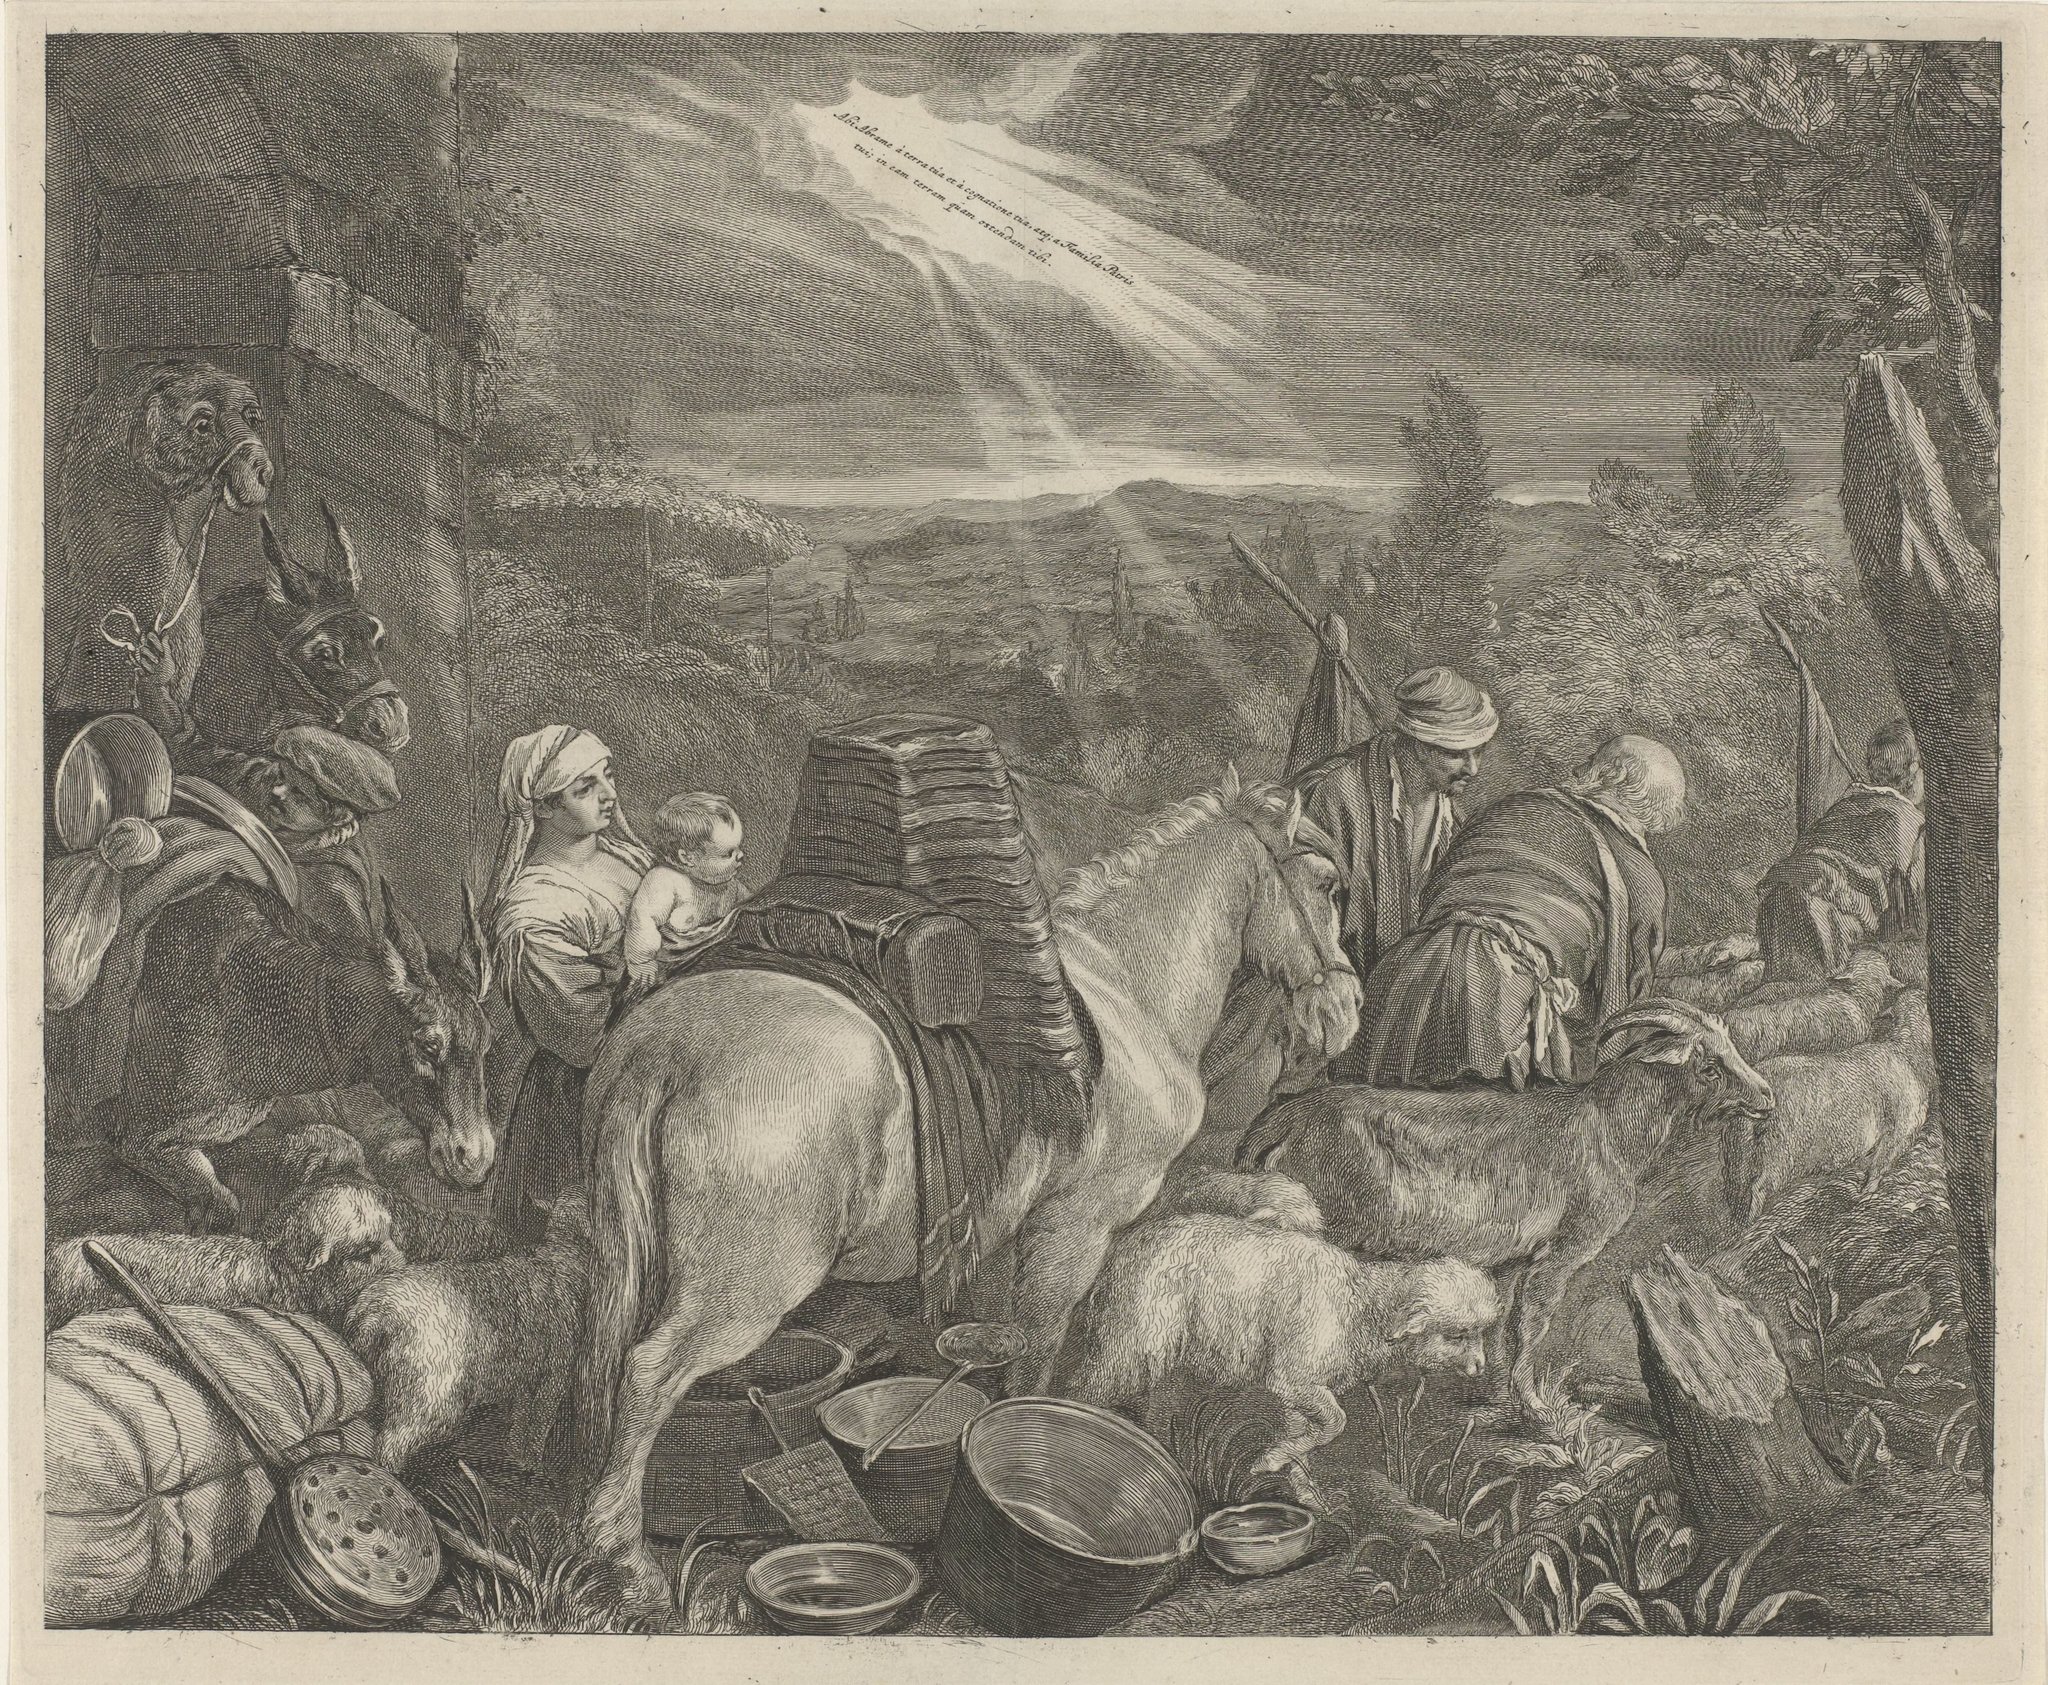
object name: print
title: Abraham verlaat Haran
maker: cornelis visscher (ii)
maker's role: draughtsman, painter, print maker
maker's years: 1628-1658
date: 1638-1658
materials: paper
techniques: engraving, etching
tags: abraham starts out for the land of canaan with sarah, lot and his belongings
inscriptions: collector's mark: Lugt 2228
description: De Amsterdamse uitgever Claes Jansz. Visscher (II) produceerde vanaf de jaren ’30 van de zeventiende eeuw grote Bijbelse prenten op zogenaamd royaal-formaat papier (ca. 480 x 580 mm). Na zijn dood in 1652 zette zijn zoon Nicolaes Visscher (I) het bedrijf voort en zo ook de uitgave van Royaalbijbelprenten. Toen Nicolaes in 1679 overleed nam zijn zoon Nicolaes Visscher (II) het bedrijf over en gaf kort hierna, omstreeks 1680, een fondslijst uit. Hierin worden 130 prenten met Bijbelse voorstellingen op royaalpapier beschreven (zie documentatie J. van der Waals). Complete prentbijbels op royaal-formaat werden door vader en zoon Nicolaes Visscher uitgegeven onder de titel Historiae Sacrae Veteris et Novi Testamenti. De bladen werden echter ook los verkocht en konden worden gecombineerd met Royaalbijbel-prenten van andere uitgevers. Verschillende Amsterdamse uitgevers brachten namelijk ook bijbelprenten op royaal-formaat uit, onder wie Clement de Jonghe en Cornelis Danckerts. De door de firma Visscher uitgegeven prenten zijn veelal vervaardigd door anonieme prentmakers naar voorbeeld van verschillende zestiende- en zeventiende-eeuwse Bijbelse prenten en prentreeksen. Veelal moesten de composities worden aangepast aan het grotere en langgerekte royaal-formaat. Daarnaast zijn er ook grote bladen van bekende prentmakers zoals Jan van Londerseel, Pieter Nolpe, Jacques de Gheyn (II) en Jan Harmensz. Muller opgenomen in de categorie ‘Bybelsche Figuren, op Royaal-bladen’ in de fondslijst van Visscher. Prent mogelijk gebruikt in: Historiae Sacrae Veteris et Novi Testamenti (Royaalbijbel). Amsterdam: Nicolaes Visscher (I) en (II), [1652-1702]. Zie exemplaar British Museum. In de fondslijst van Nicolaes Visscher II (ca. 1680) wordt deze prent niet genoemd.